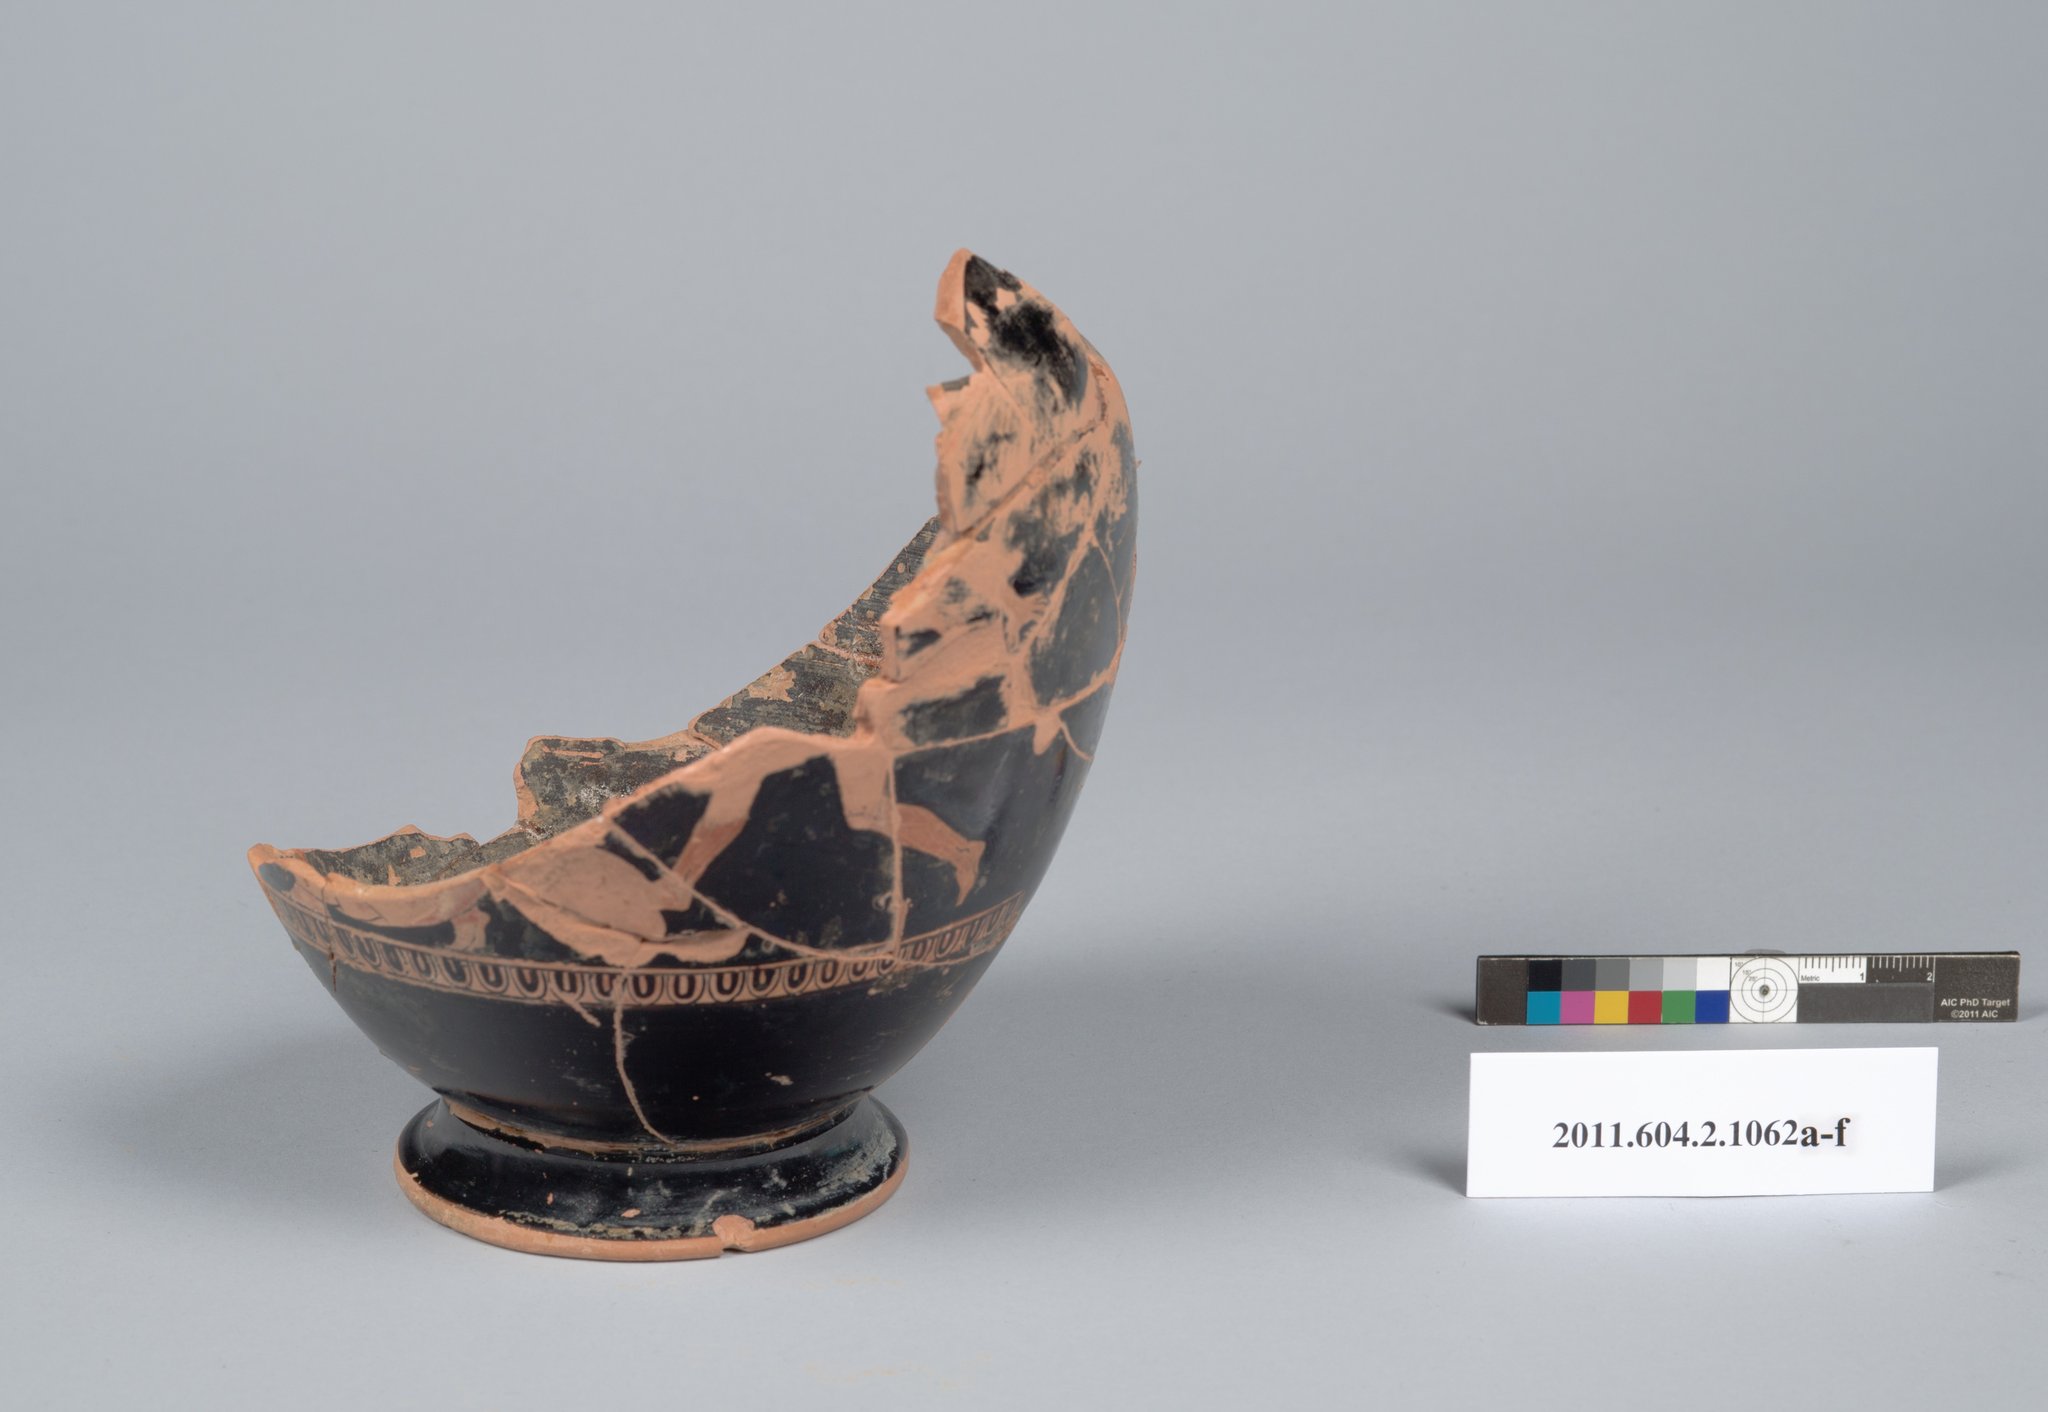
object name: oinochoe fragment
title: Terracotta fragments of an oinochoe (jug)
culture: greek, attic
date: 480-470 BCE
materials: terracotta